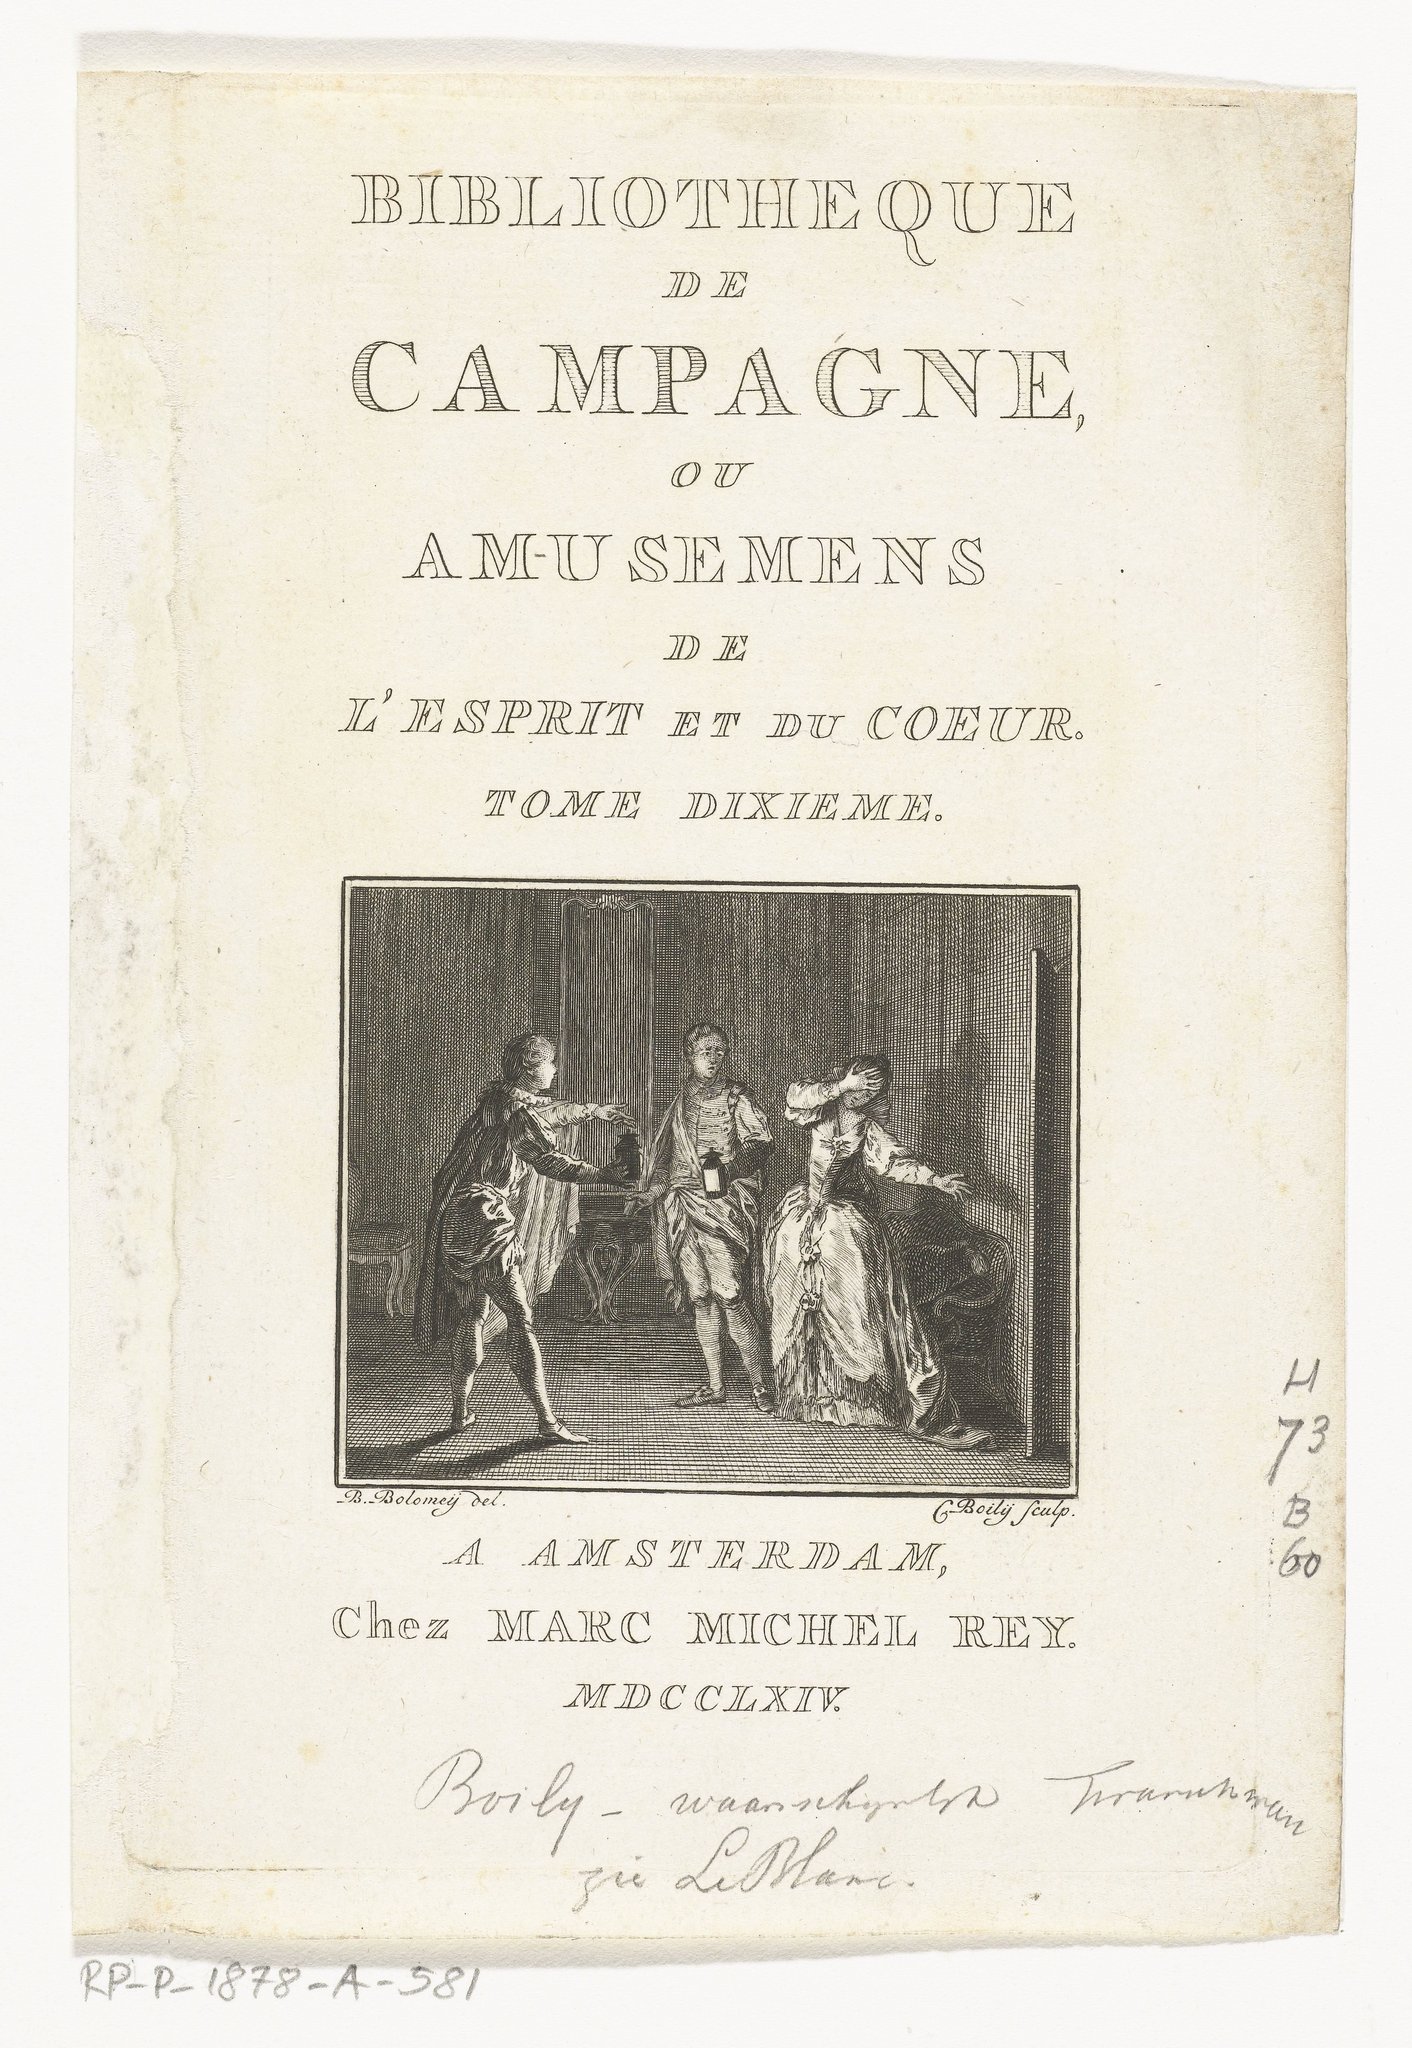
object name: titelblad, titelpagina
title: Titelpagina voor: Bibliothèque de Campagne. Tome dixième, Amsterdam, 1764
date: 1764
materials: paper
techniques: etching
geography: amsterdam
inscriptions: collector's mark: Lugt 2228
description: Een vrouw komt 's-nachts uit haar kamer, op de gang komt ze twee mannen met lantaarns tegen.